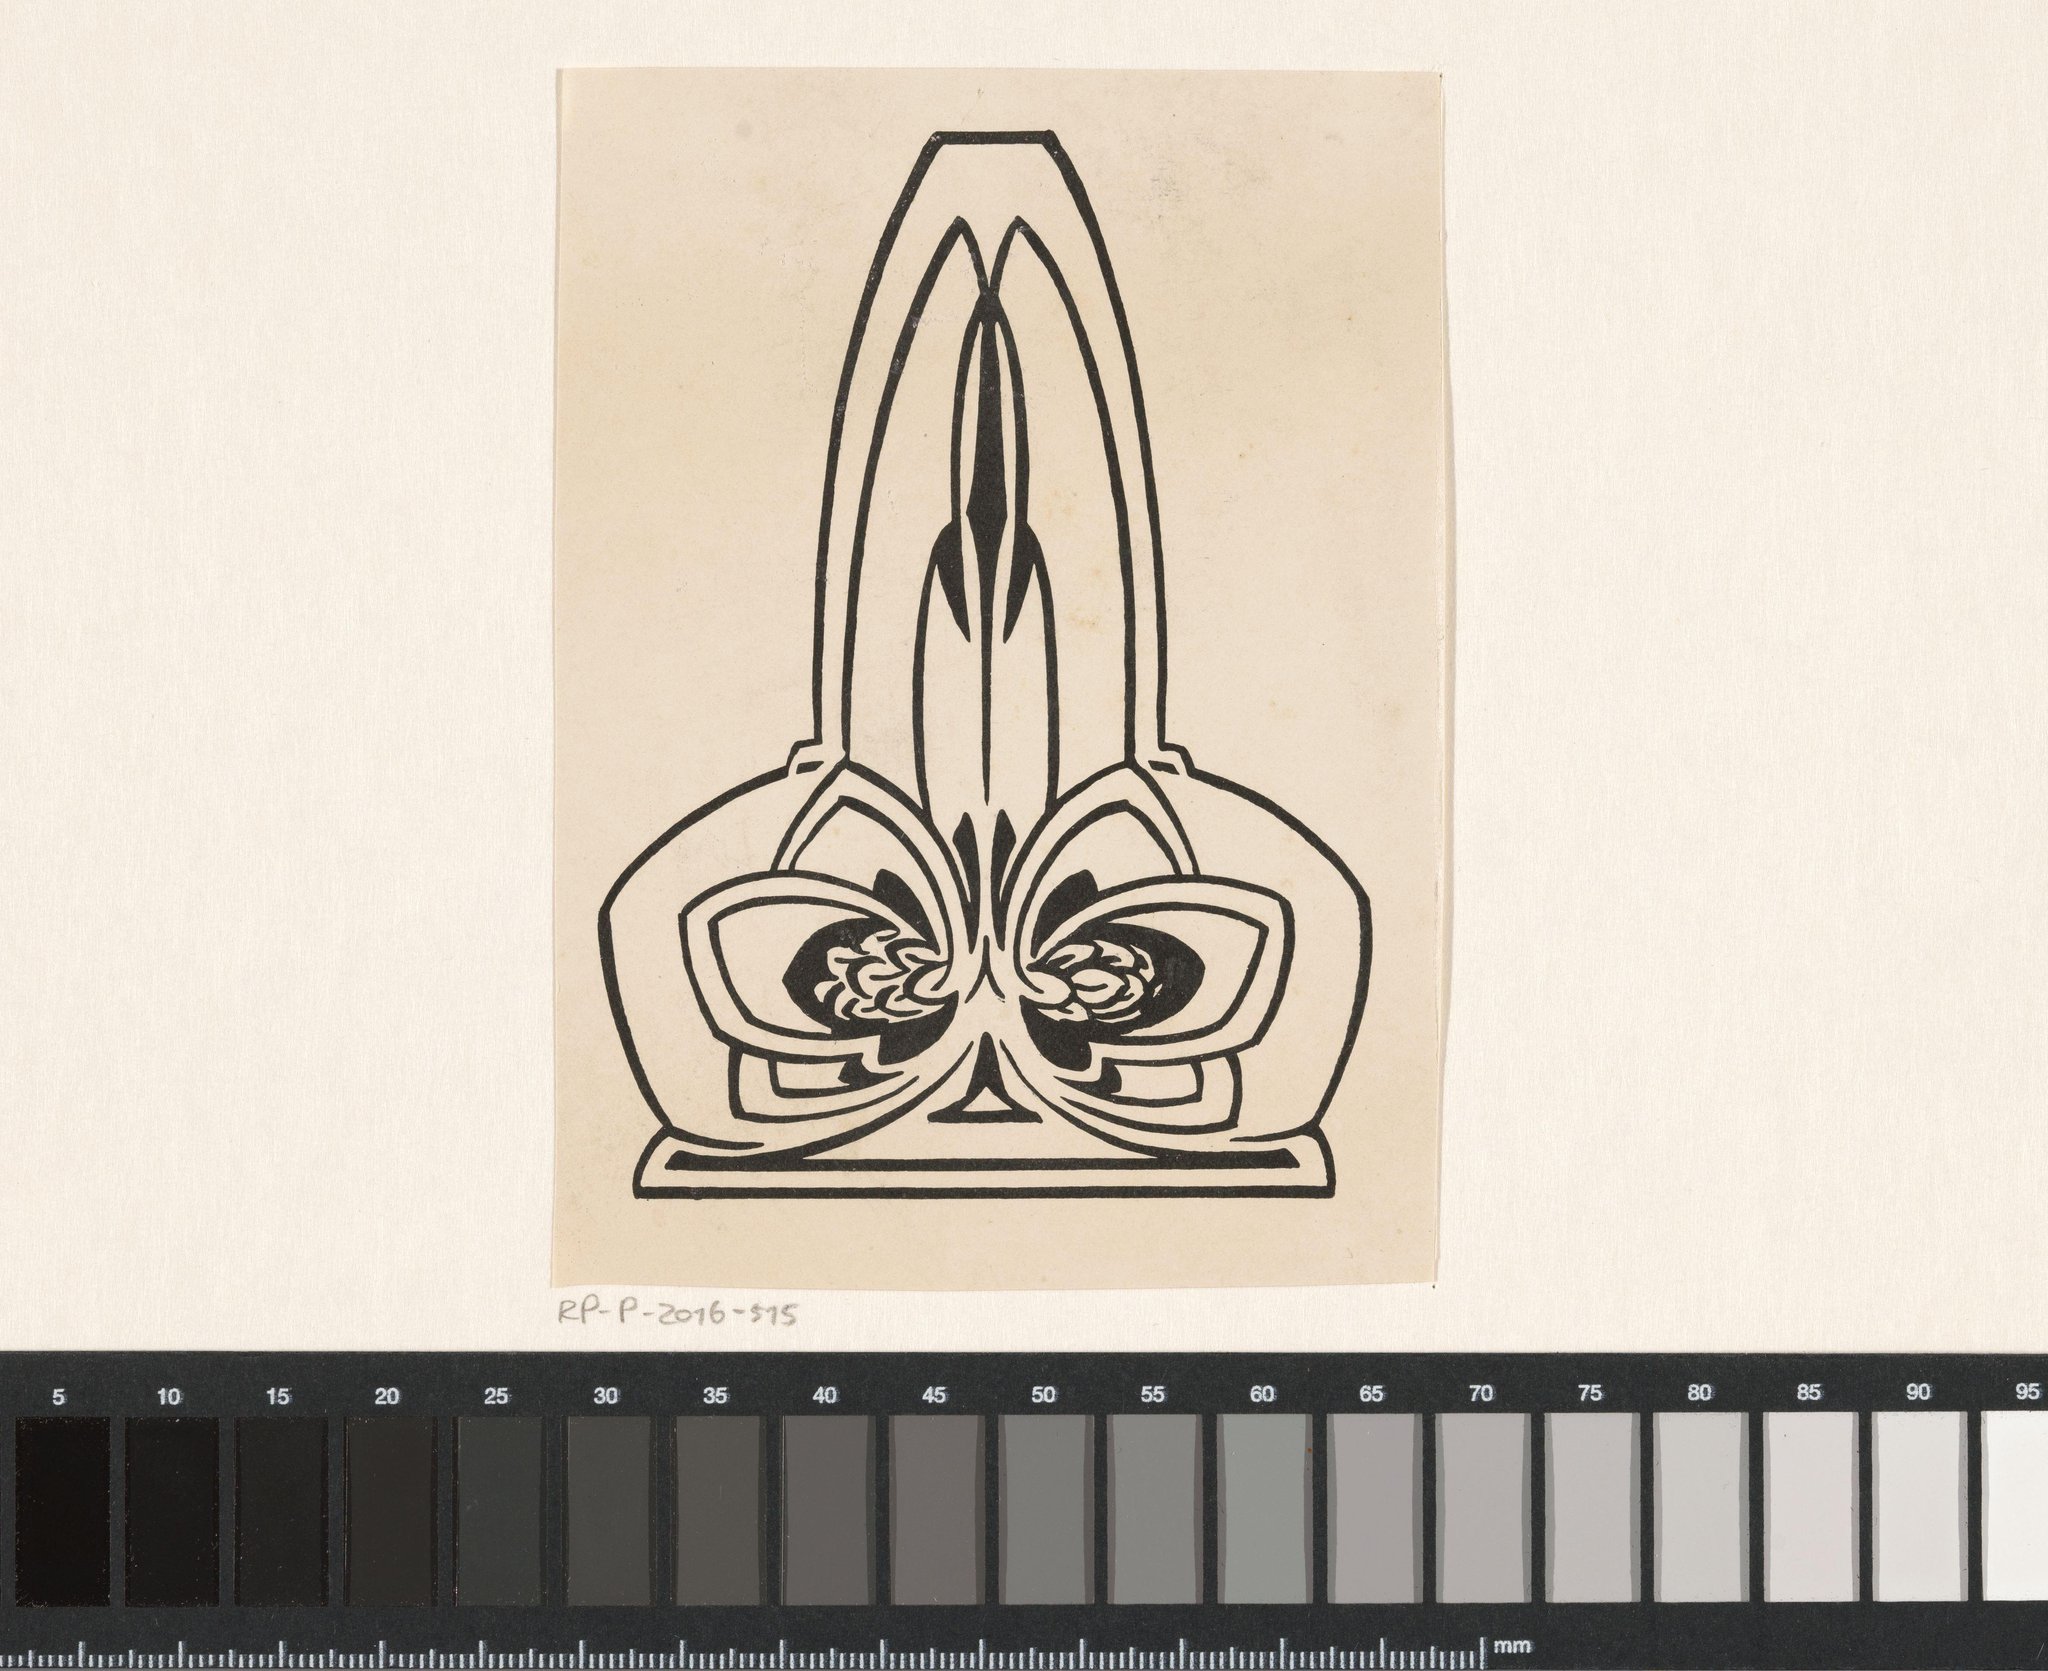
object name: boekillustratie ontwerp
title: Ornament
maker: Anonymous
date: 1904-1919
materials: paper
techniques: printing block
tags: ornament ~ tracery, flowers ~ ornament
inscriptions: collector's mark: Lugt 2228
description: Vermoedelijk een ontwerp voor: Gezelle, Guido. Motto-album. Amsterdam: Veen, 1904 en 1919.